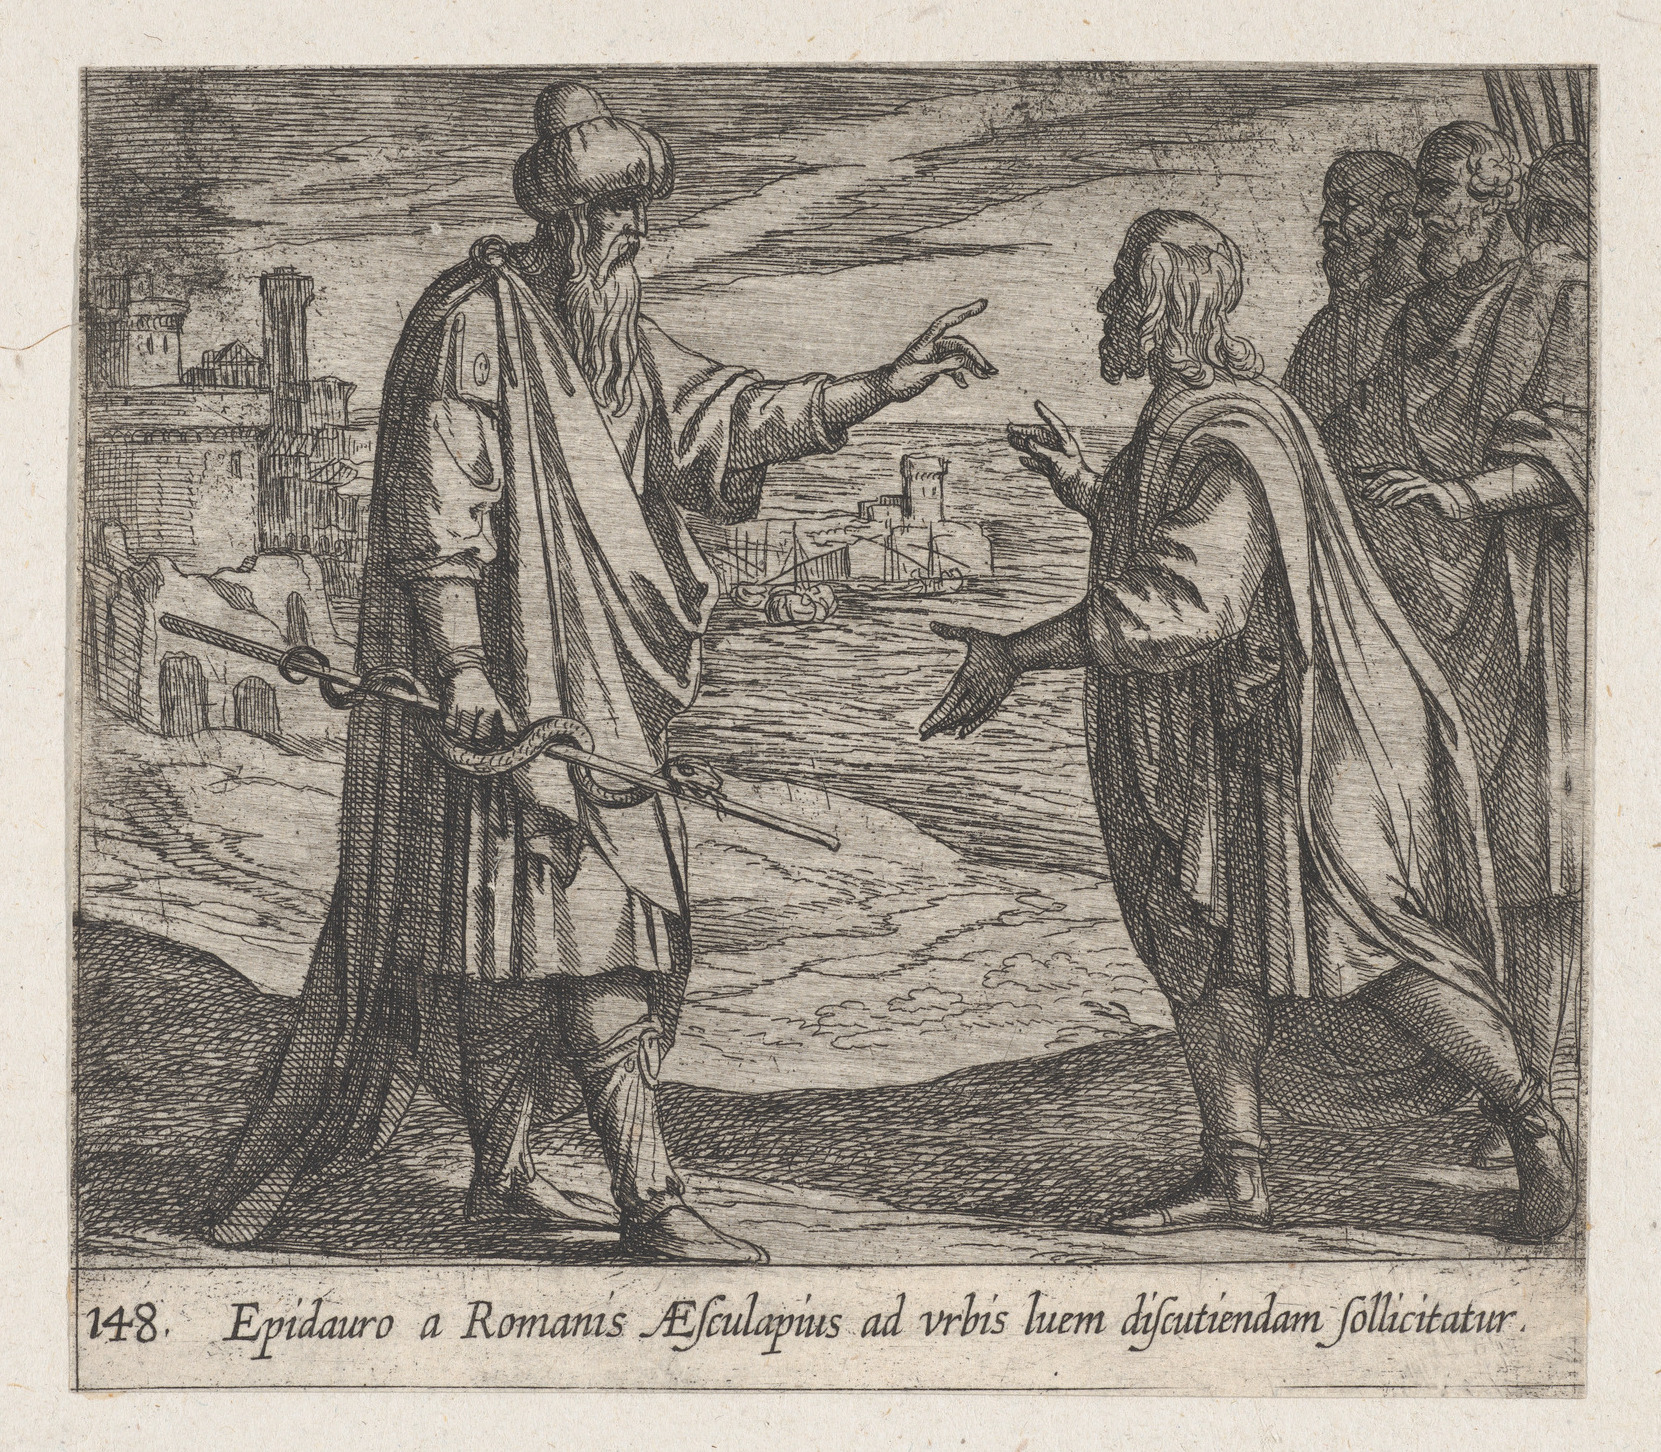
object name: print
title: Plate 148: Aesculapius Speaking to the Romans (Epidauro a Romanis AEsculapius ad urbis luem discutiendam sollicitatur), from Ovid's 'Metamorphoses'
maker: antonio tempesta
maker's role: artist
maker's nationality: italian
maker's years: 1555-1630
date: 1606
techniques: etching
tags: men,snakes